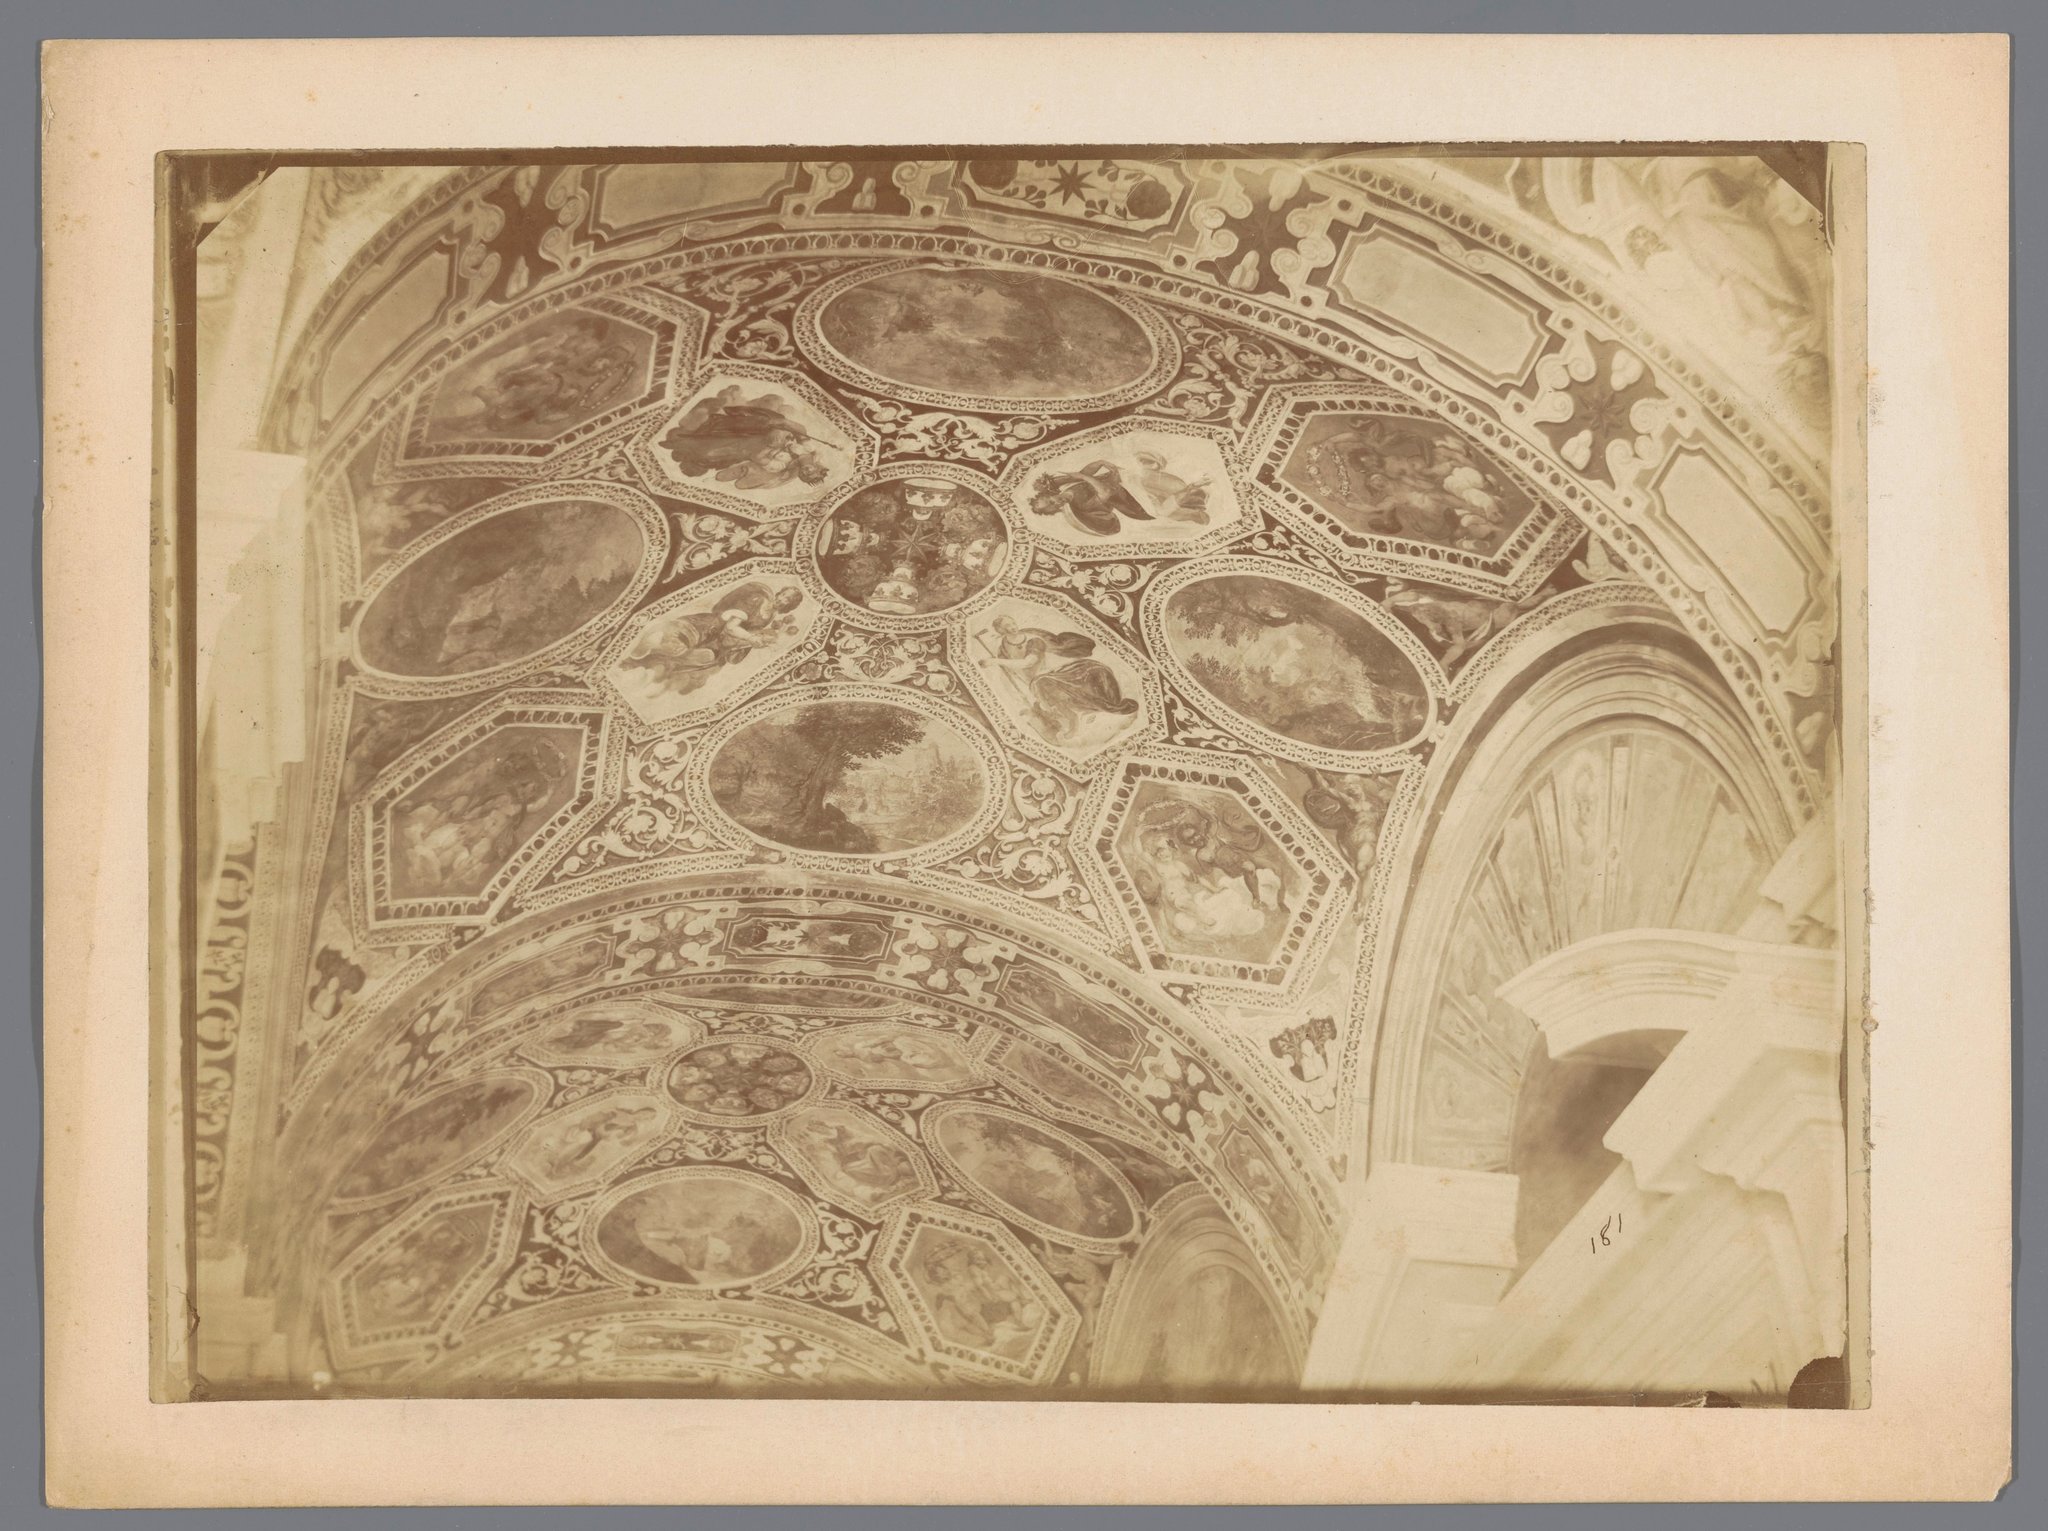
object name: photograph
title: Plafondschilderingen in de Vaticaanse Musea te Vaticaanstad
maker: gustave eugène chauffourier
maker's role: fotograaf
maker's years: 1845-1919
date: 1875-1900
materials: photographic support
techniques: albumen print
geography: vatican museums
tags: (decorated) ceiling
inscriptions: collector's mark: Lugt 3937, number: ‘181’